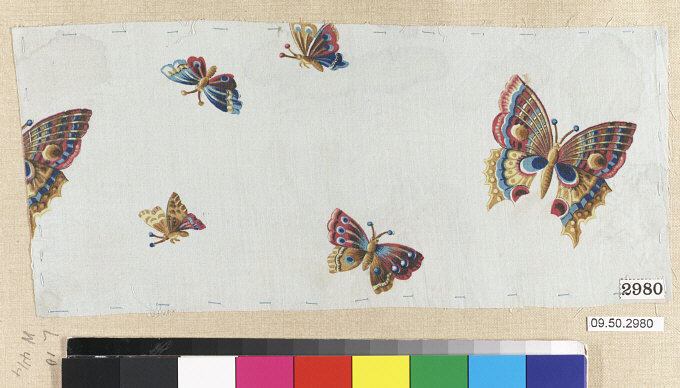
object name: piece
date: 1801-1900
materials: cotton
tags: butterflies